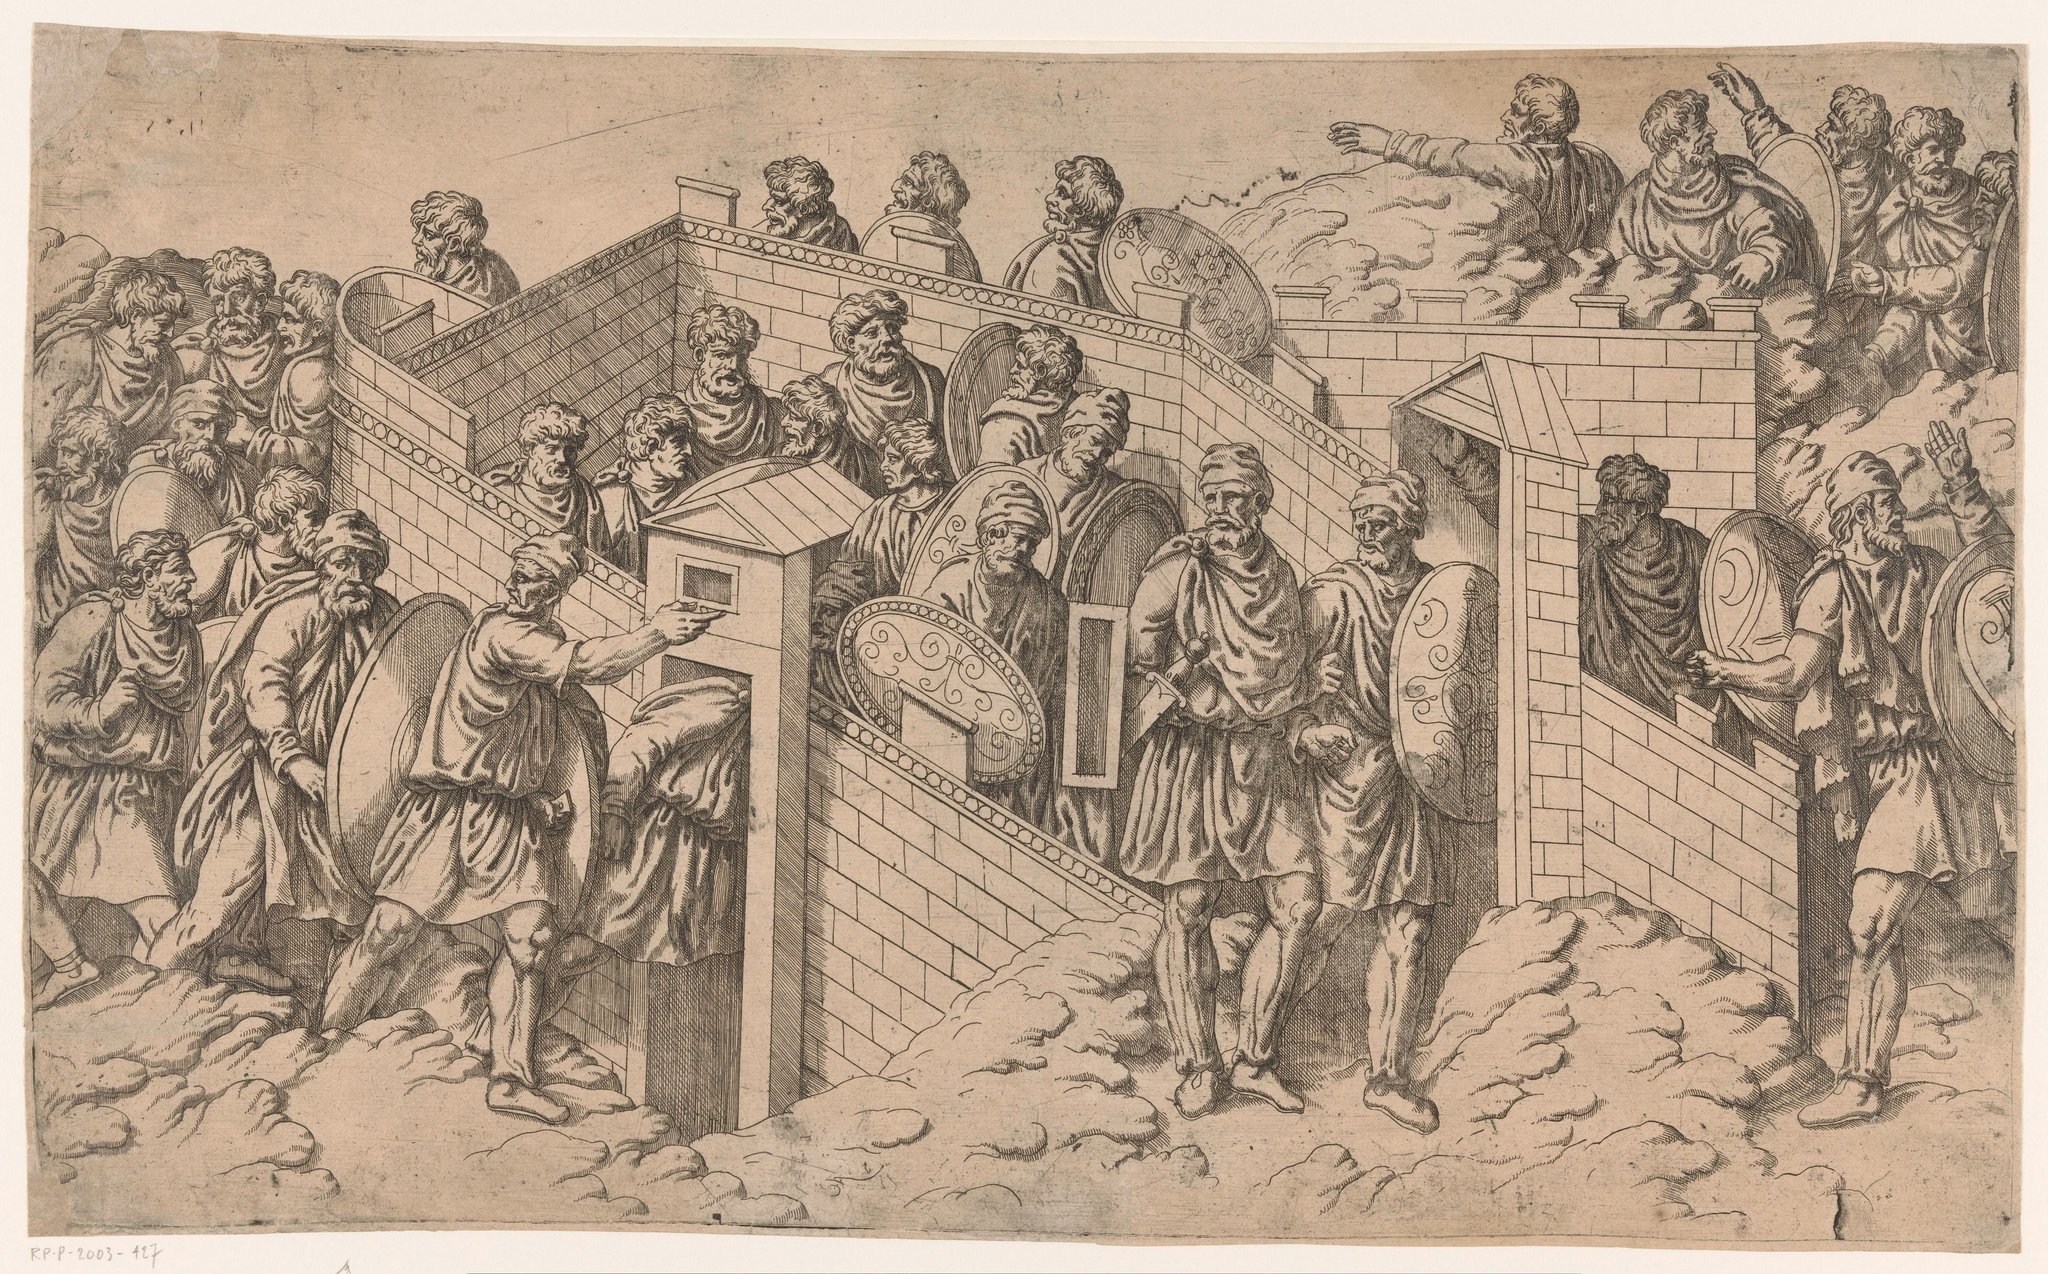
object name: print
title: Scène uit de Dacische Oorlogen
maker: antonio fantuzzi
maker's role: painter, print maker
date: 1537-1550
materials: paper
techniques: etching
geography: fontainebleau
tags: (story of) the emperor trajan, triumphal column with helical friezes, piece of sculpture, reproduction of a piece of sculpture, war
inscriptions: collector's mark: Lugt 2228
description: Deze prent maakt deel uit van een fries bestaande uit een onbekend aantal prenten met voorstellingen naar het bas-reliëf op de Zuil van Trajanus te Rome. De voorstellingen op de prenten in de collectie Rijksmuseum sluiten niet op elkaar aan.